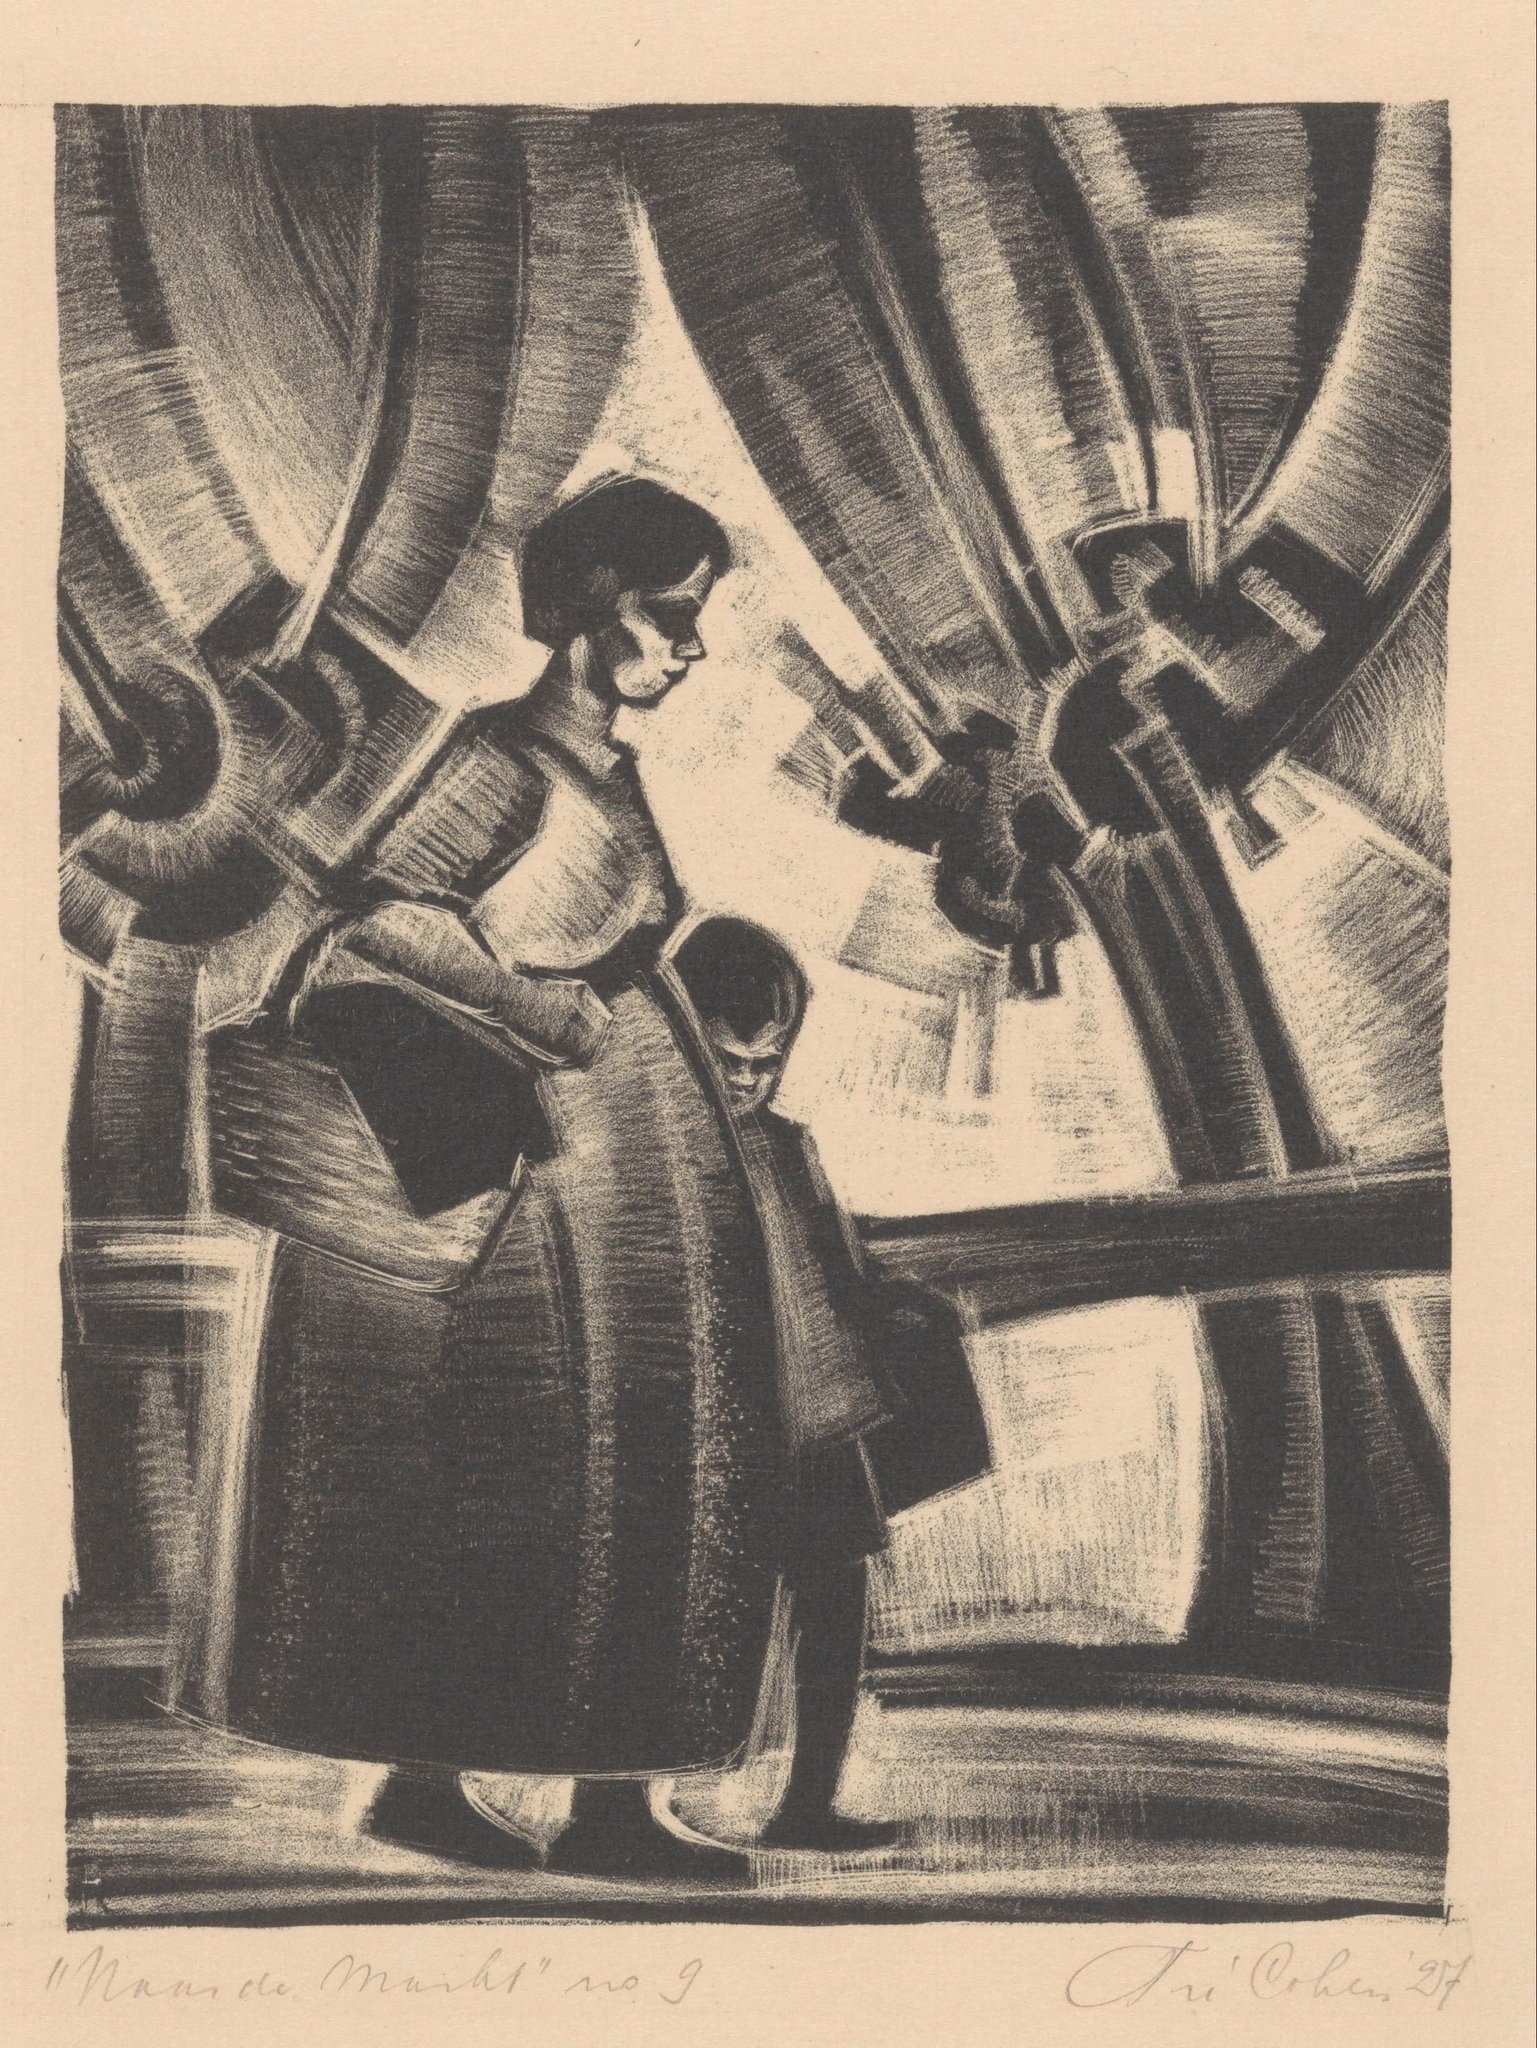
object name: print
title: Naar de markt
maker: fré cohen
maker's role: draughtsman, print maker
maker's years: 1903-1943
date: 1927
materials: paper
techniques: lithograph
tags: carrying something in basket, bag, rucksack, etc., market, mother and child(ren), woman and child(ren) (family group)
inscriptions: collector's mark: Lugt 2228, number: ‘no. 9’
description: Een vrouw en een jongen lopen over straat. Ze hebben beiden een mand bij zich.